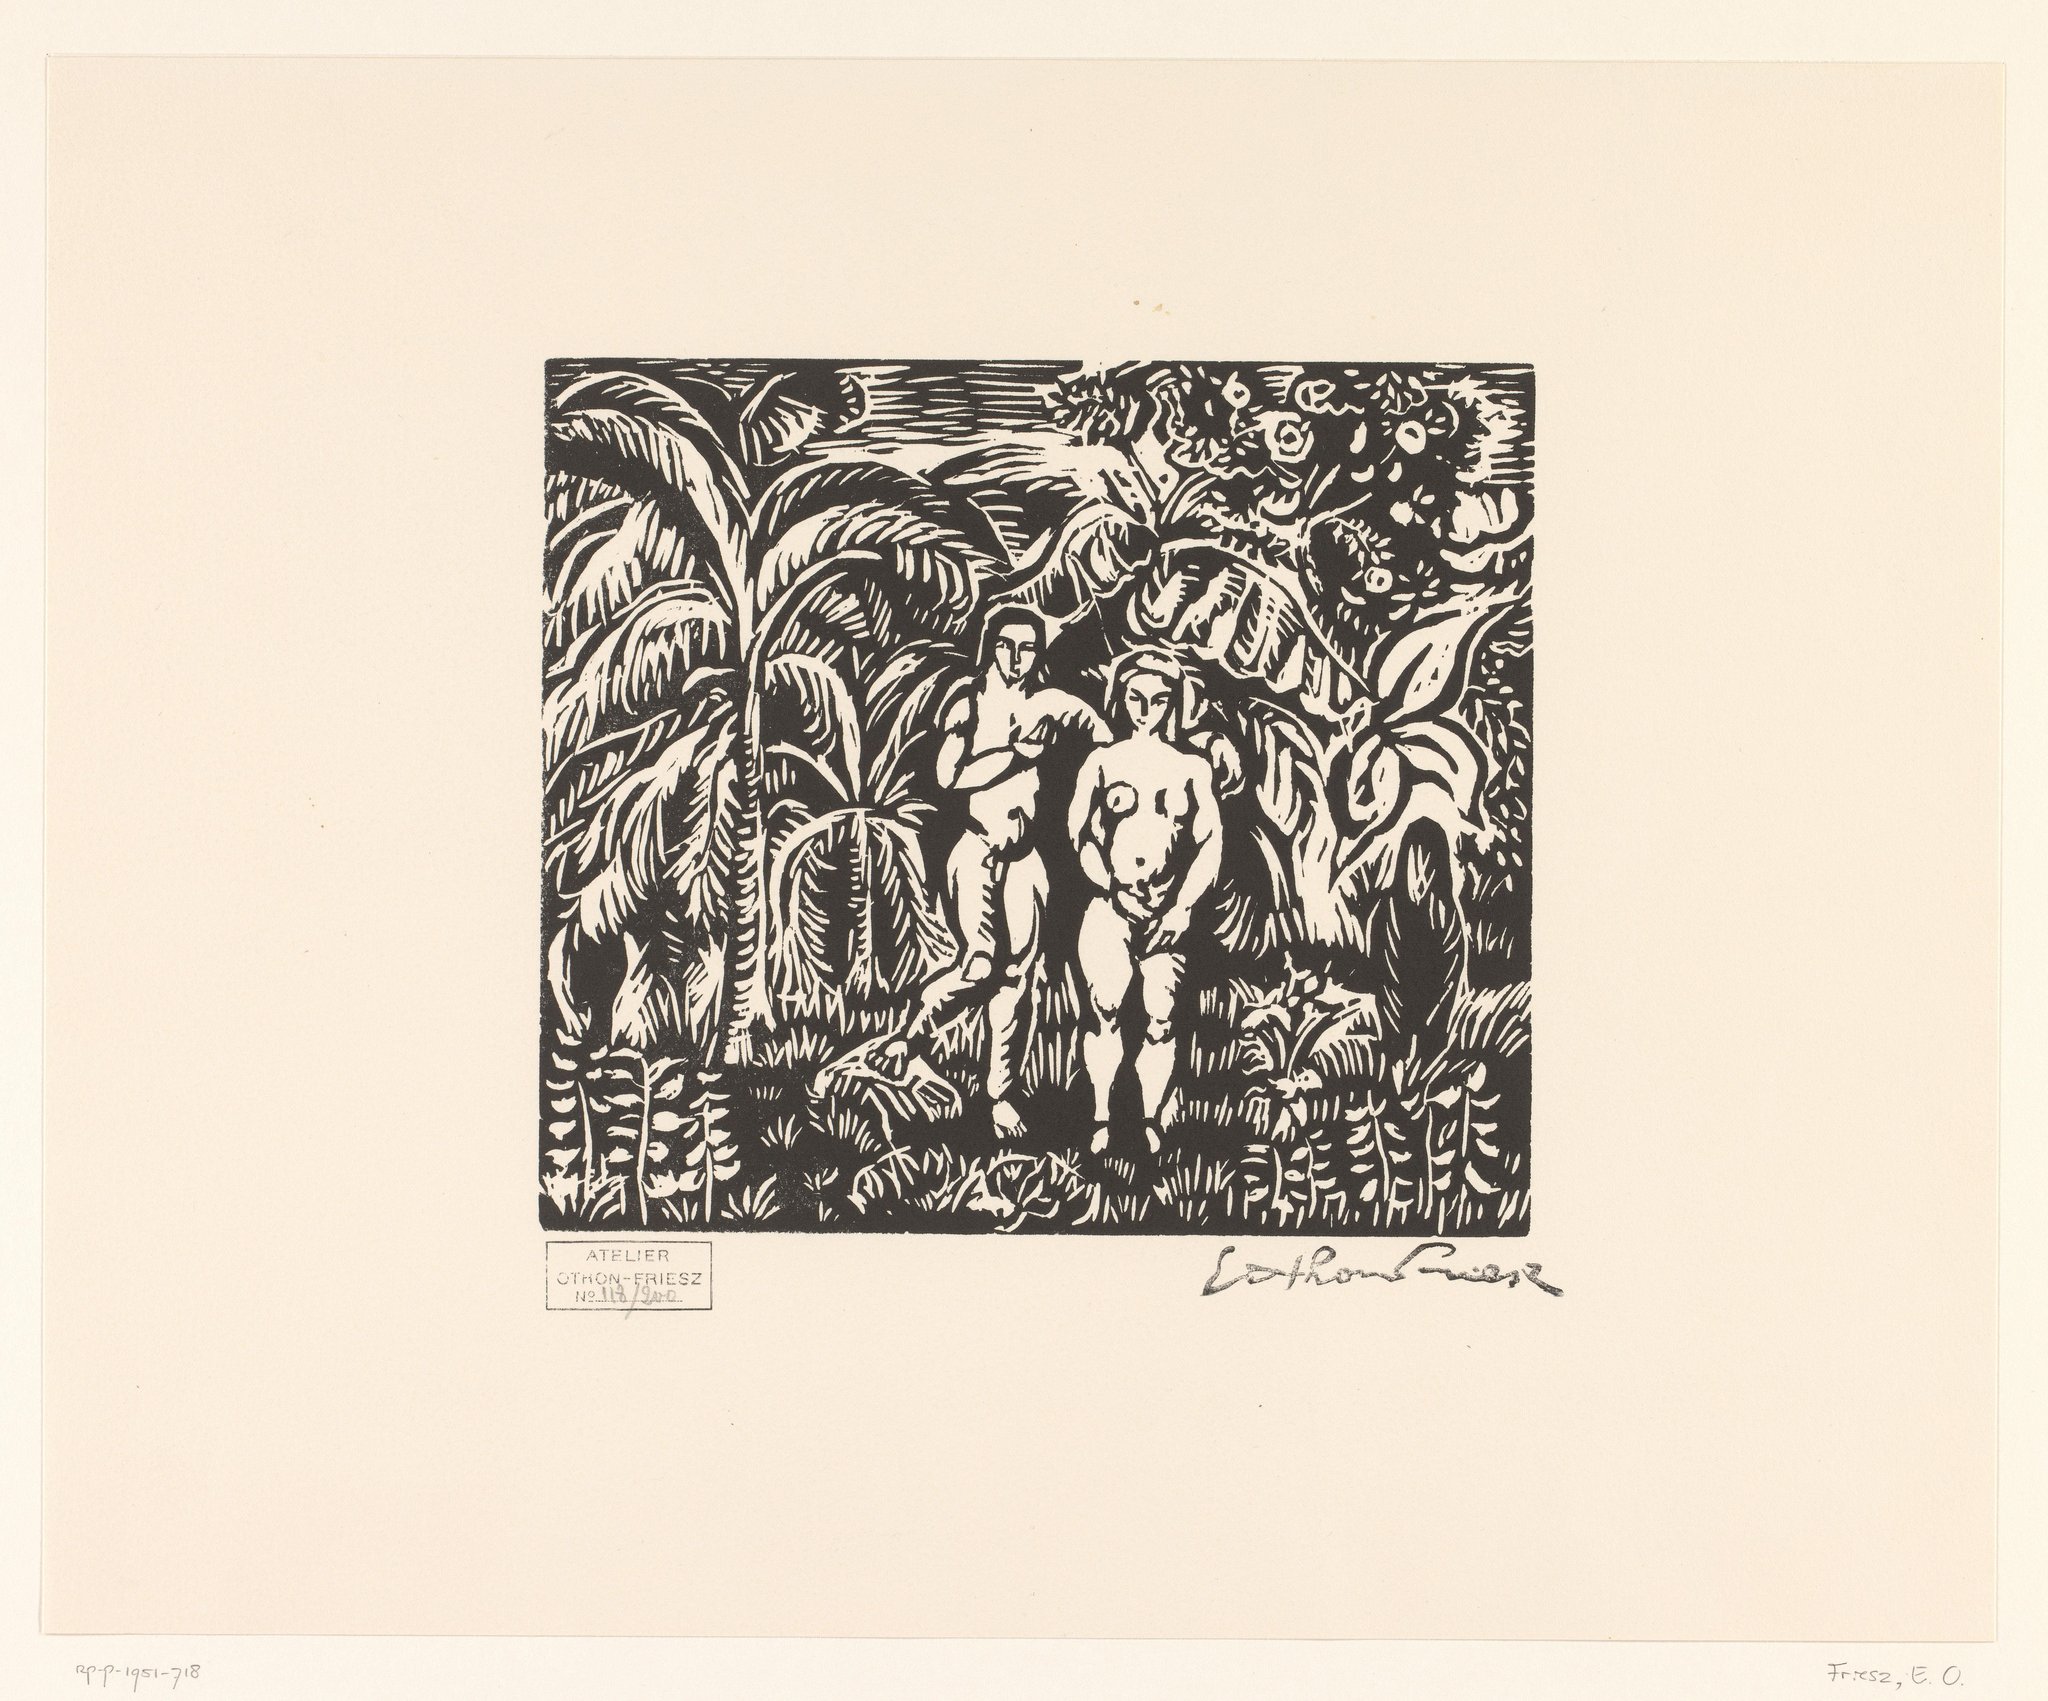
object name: print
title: Adam en Eva in het paradijs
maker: emile othon friesz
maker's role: print maker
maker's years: 1879-1949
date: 1948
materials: paper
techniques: linocut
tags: genesis from the creation to the expulsion from paradise, and later years of adam and eve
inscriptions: collector's mark: Lugt 2760, collector's mark: Lugt 2228